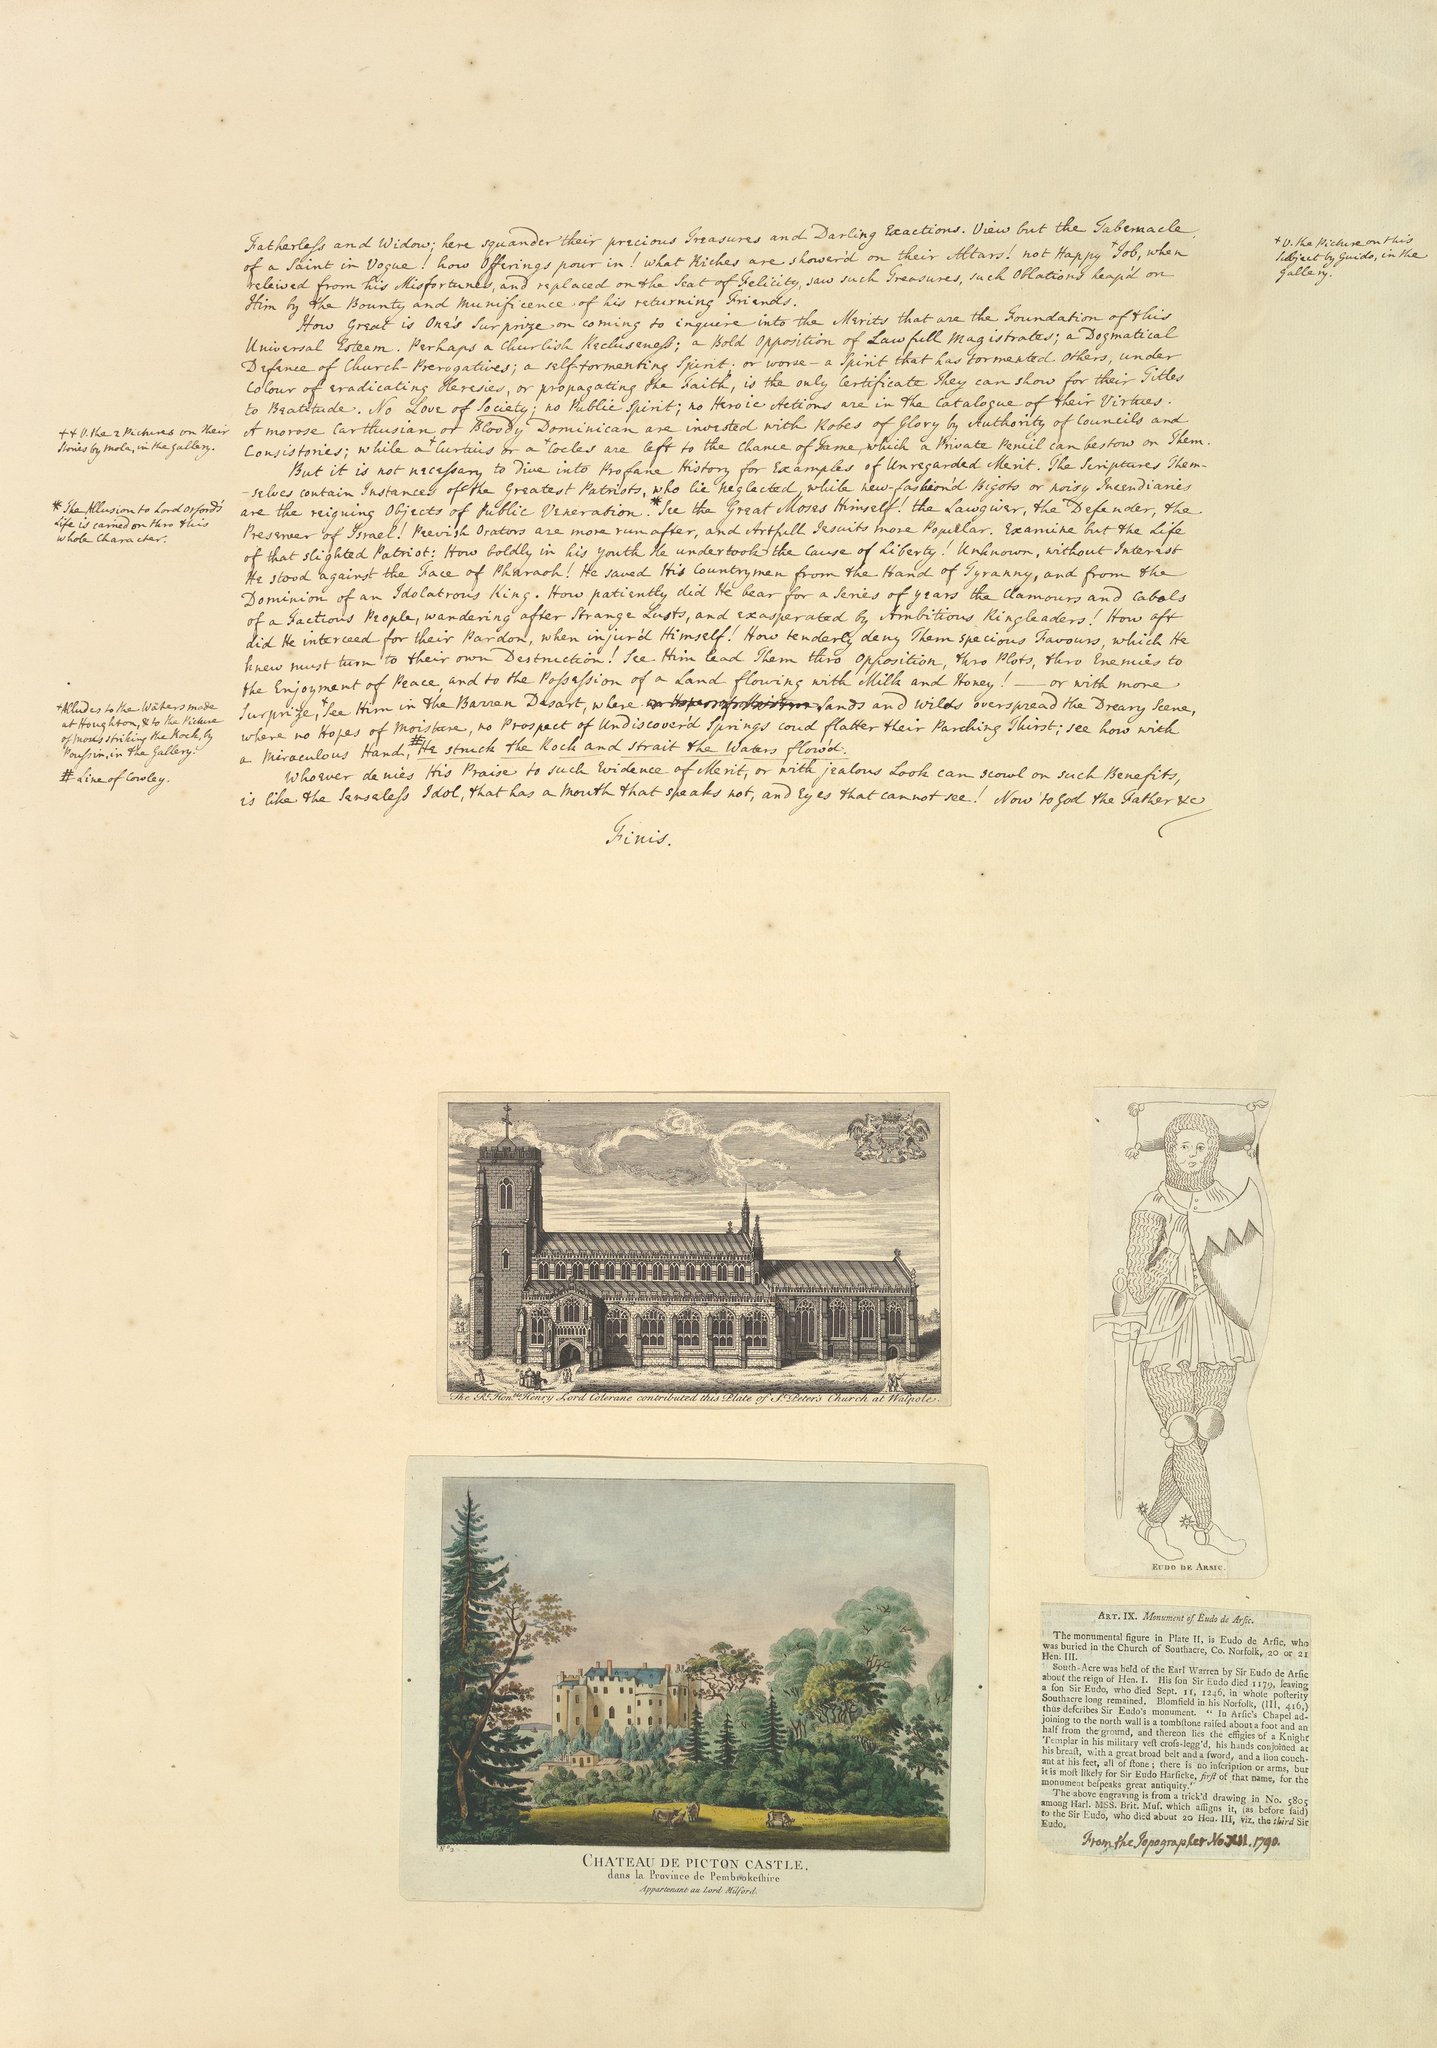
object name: manuscript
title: Leaf from Aedes Walpolinae mounted with a hand-written sheet, two prints and a printed sheet with drawn additions: (a): Sermon on Painting, continued; (b): St. Peter's Church at Walpole; (c): Chateau de Picton; (d): Monument of Eudo de Arsie; (e) Printed text describing Monument of Eudo de Arsie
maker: horace walpole, 4th earl of orford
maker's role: author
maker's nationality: british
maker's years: 1717-1797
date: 1742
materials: ink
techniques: engraving, etching, hand coloring, pen, printing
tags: churches